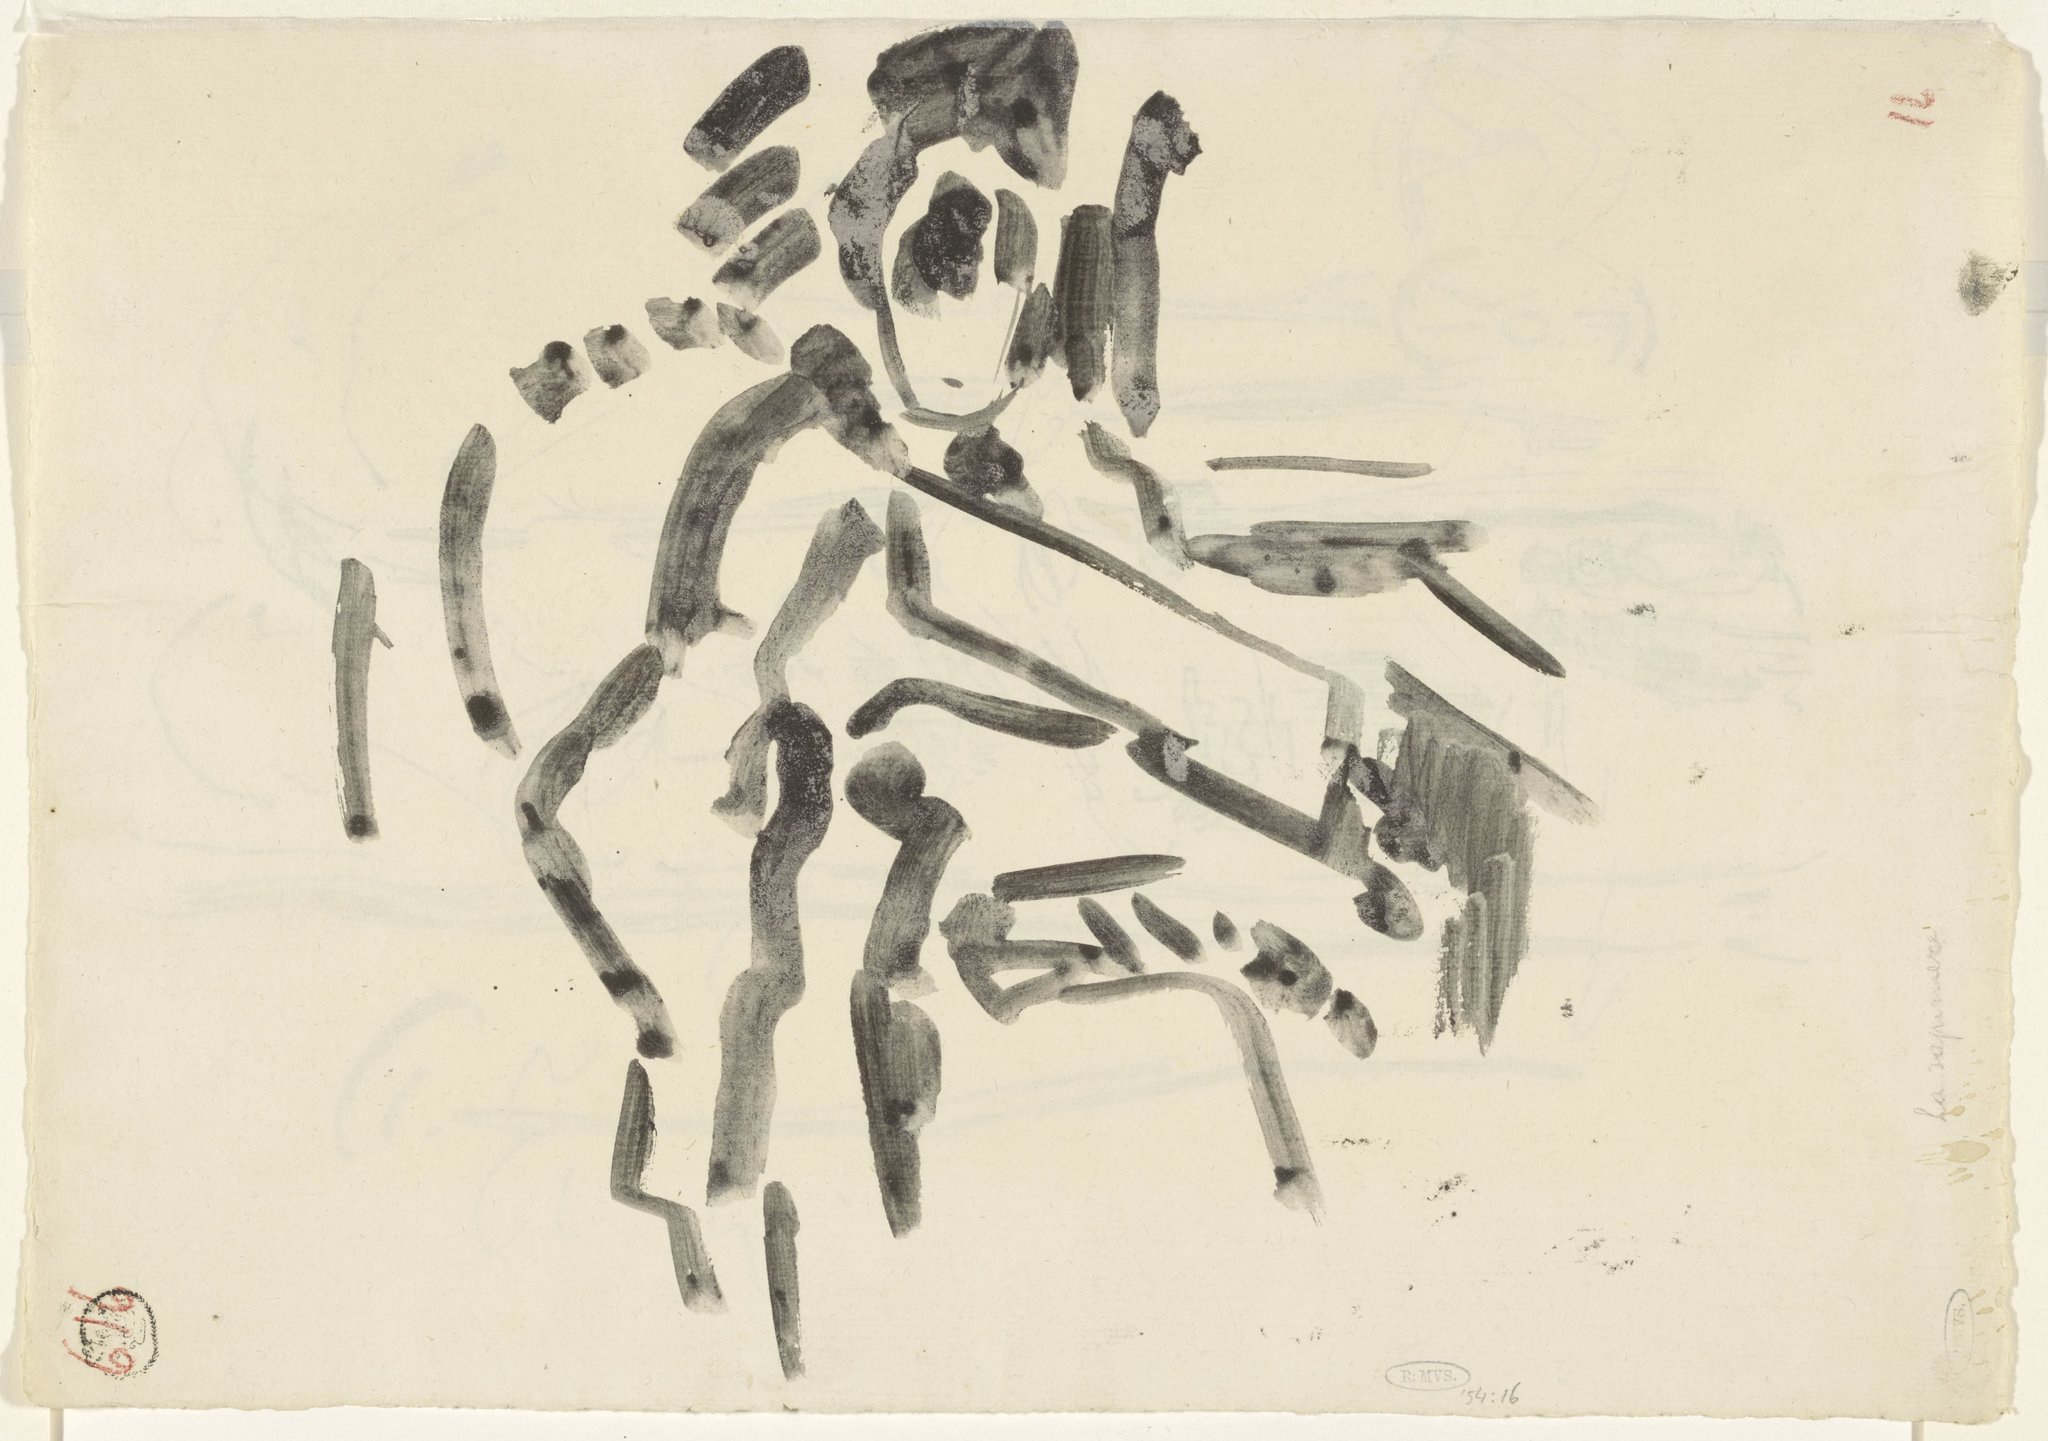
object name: drawing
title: Schets van een zittende figuur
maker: rik wouters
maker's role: draughtsman, print maker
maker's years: 1882-1916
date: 1892-1916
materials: paper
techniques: brush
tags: sitting figure